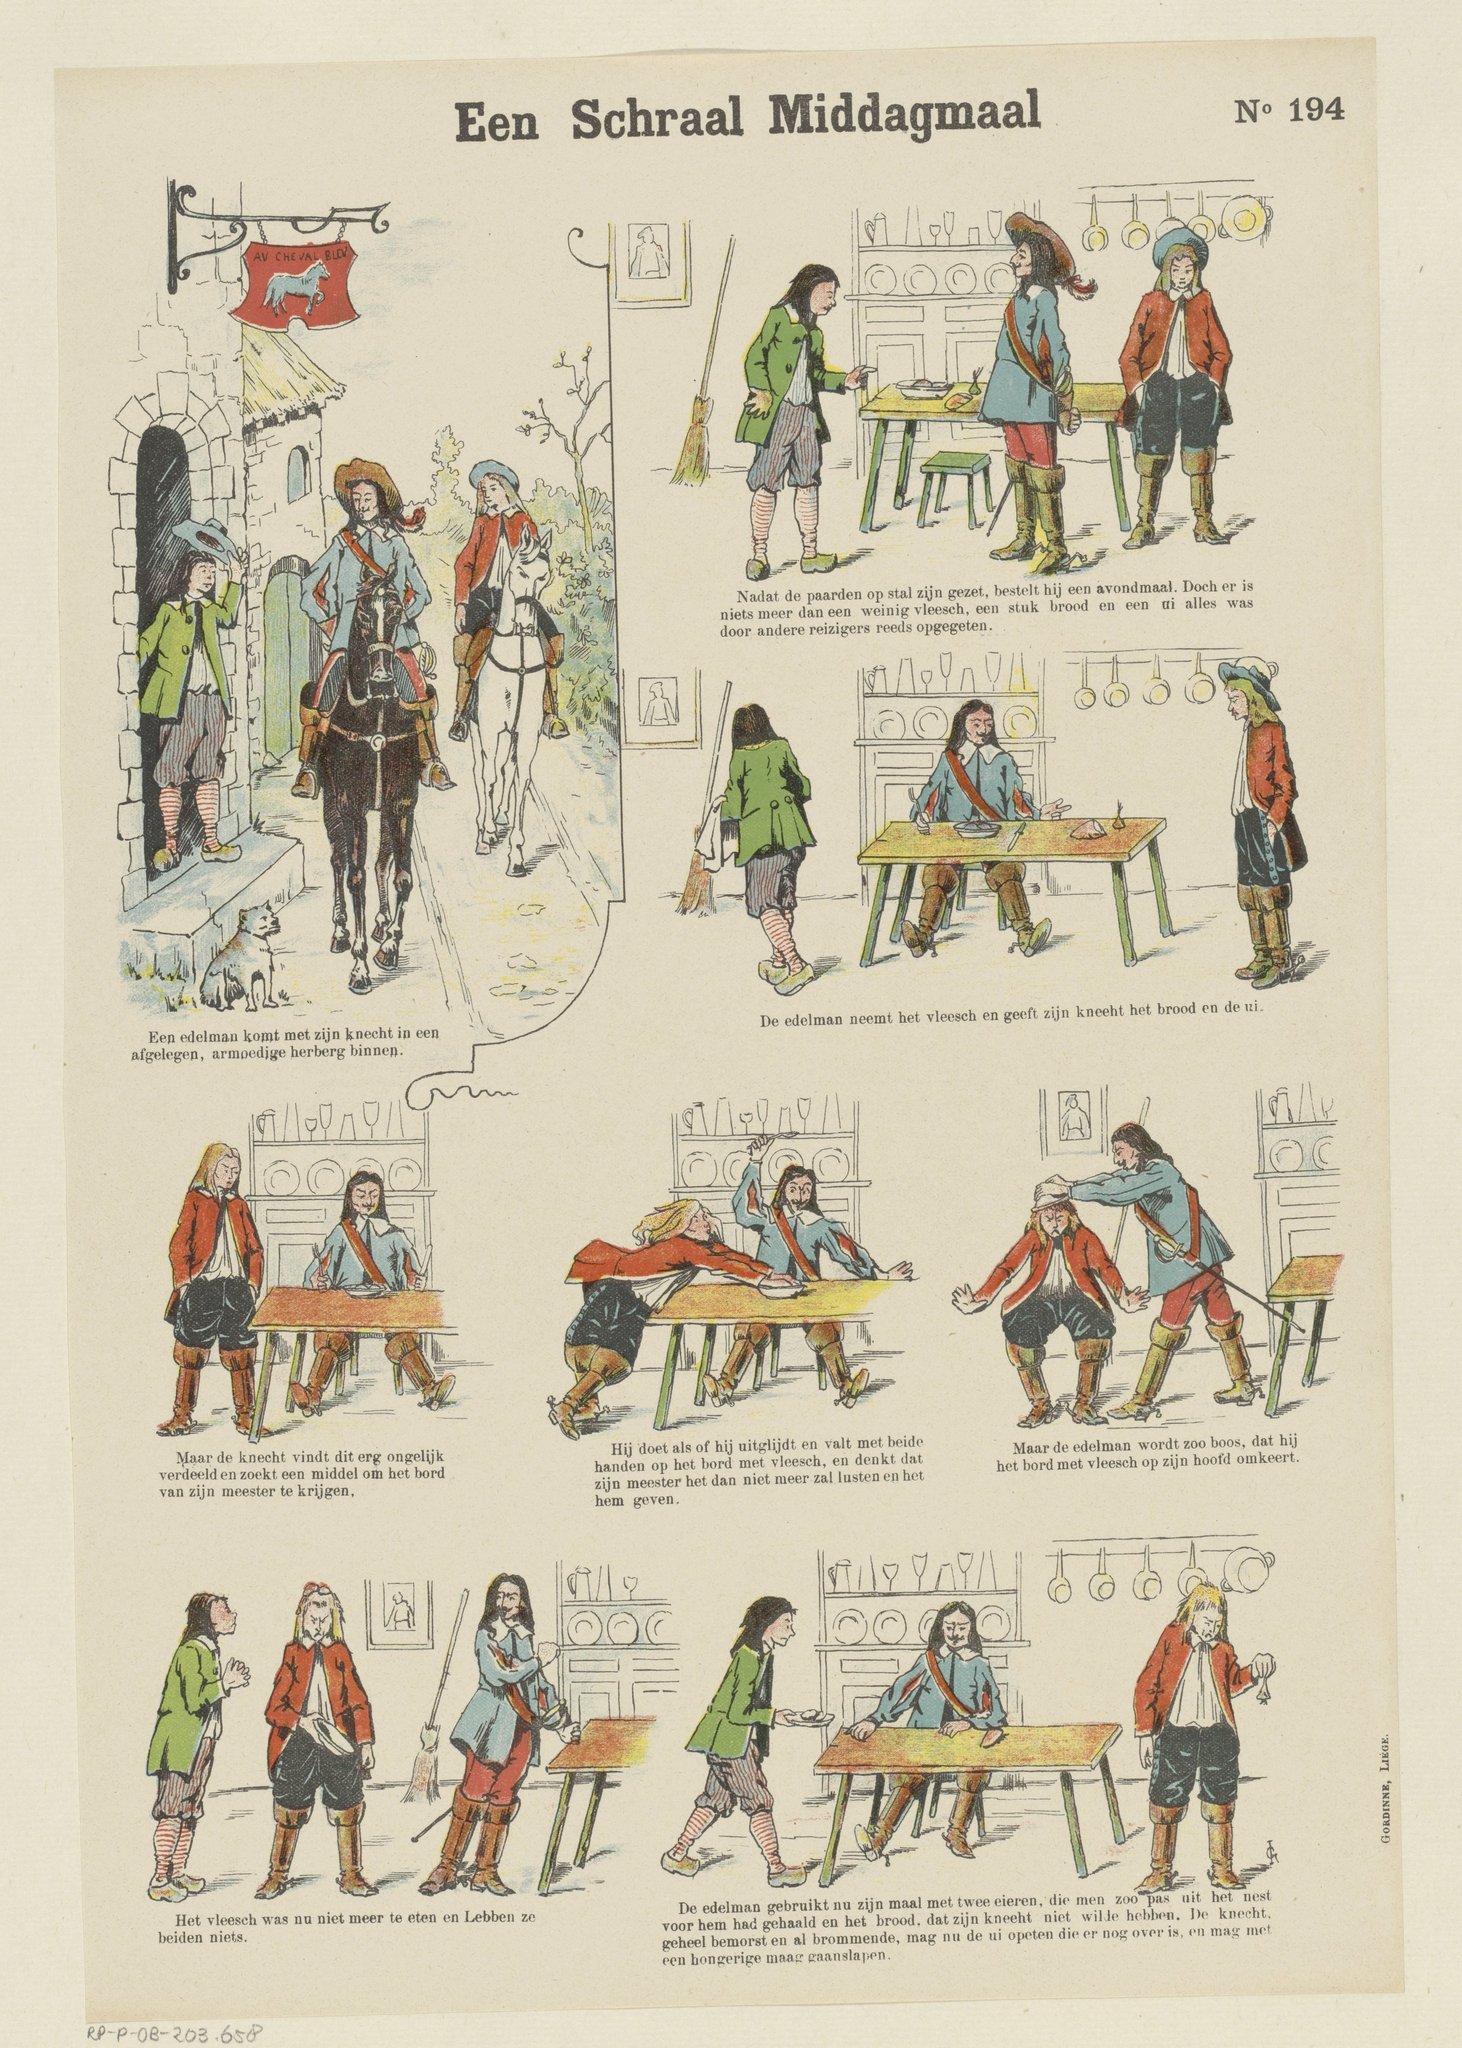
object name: popular print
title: Een schraal middagmaal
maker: monogrammist jgr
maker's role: print maker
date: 1894-1959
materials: paper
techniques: lithograph, letterpress printing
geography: liège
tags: midday meal, lunch, nobility and patriciate; chivalry, knighthood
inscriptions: collector's mark: Lugt 2760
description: Blad met 8 voorstellingen over een edelman en zijn knecht die een middagmaal proberen te verdelen. Onder elke afbeelding een onderschrift. Genummerd rechtsboven: No 194.